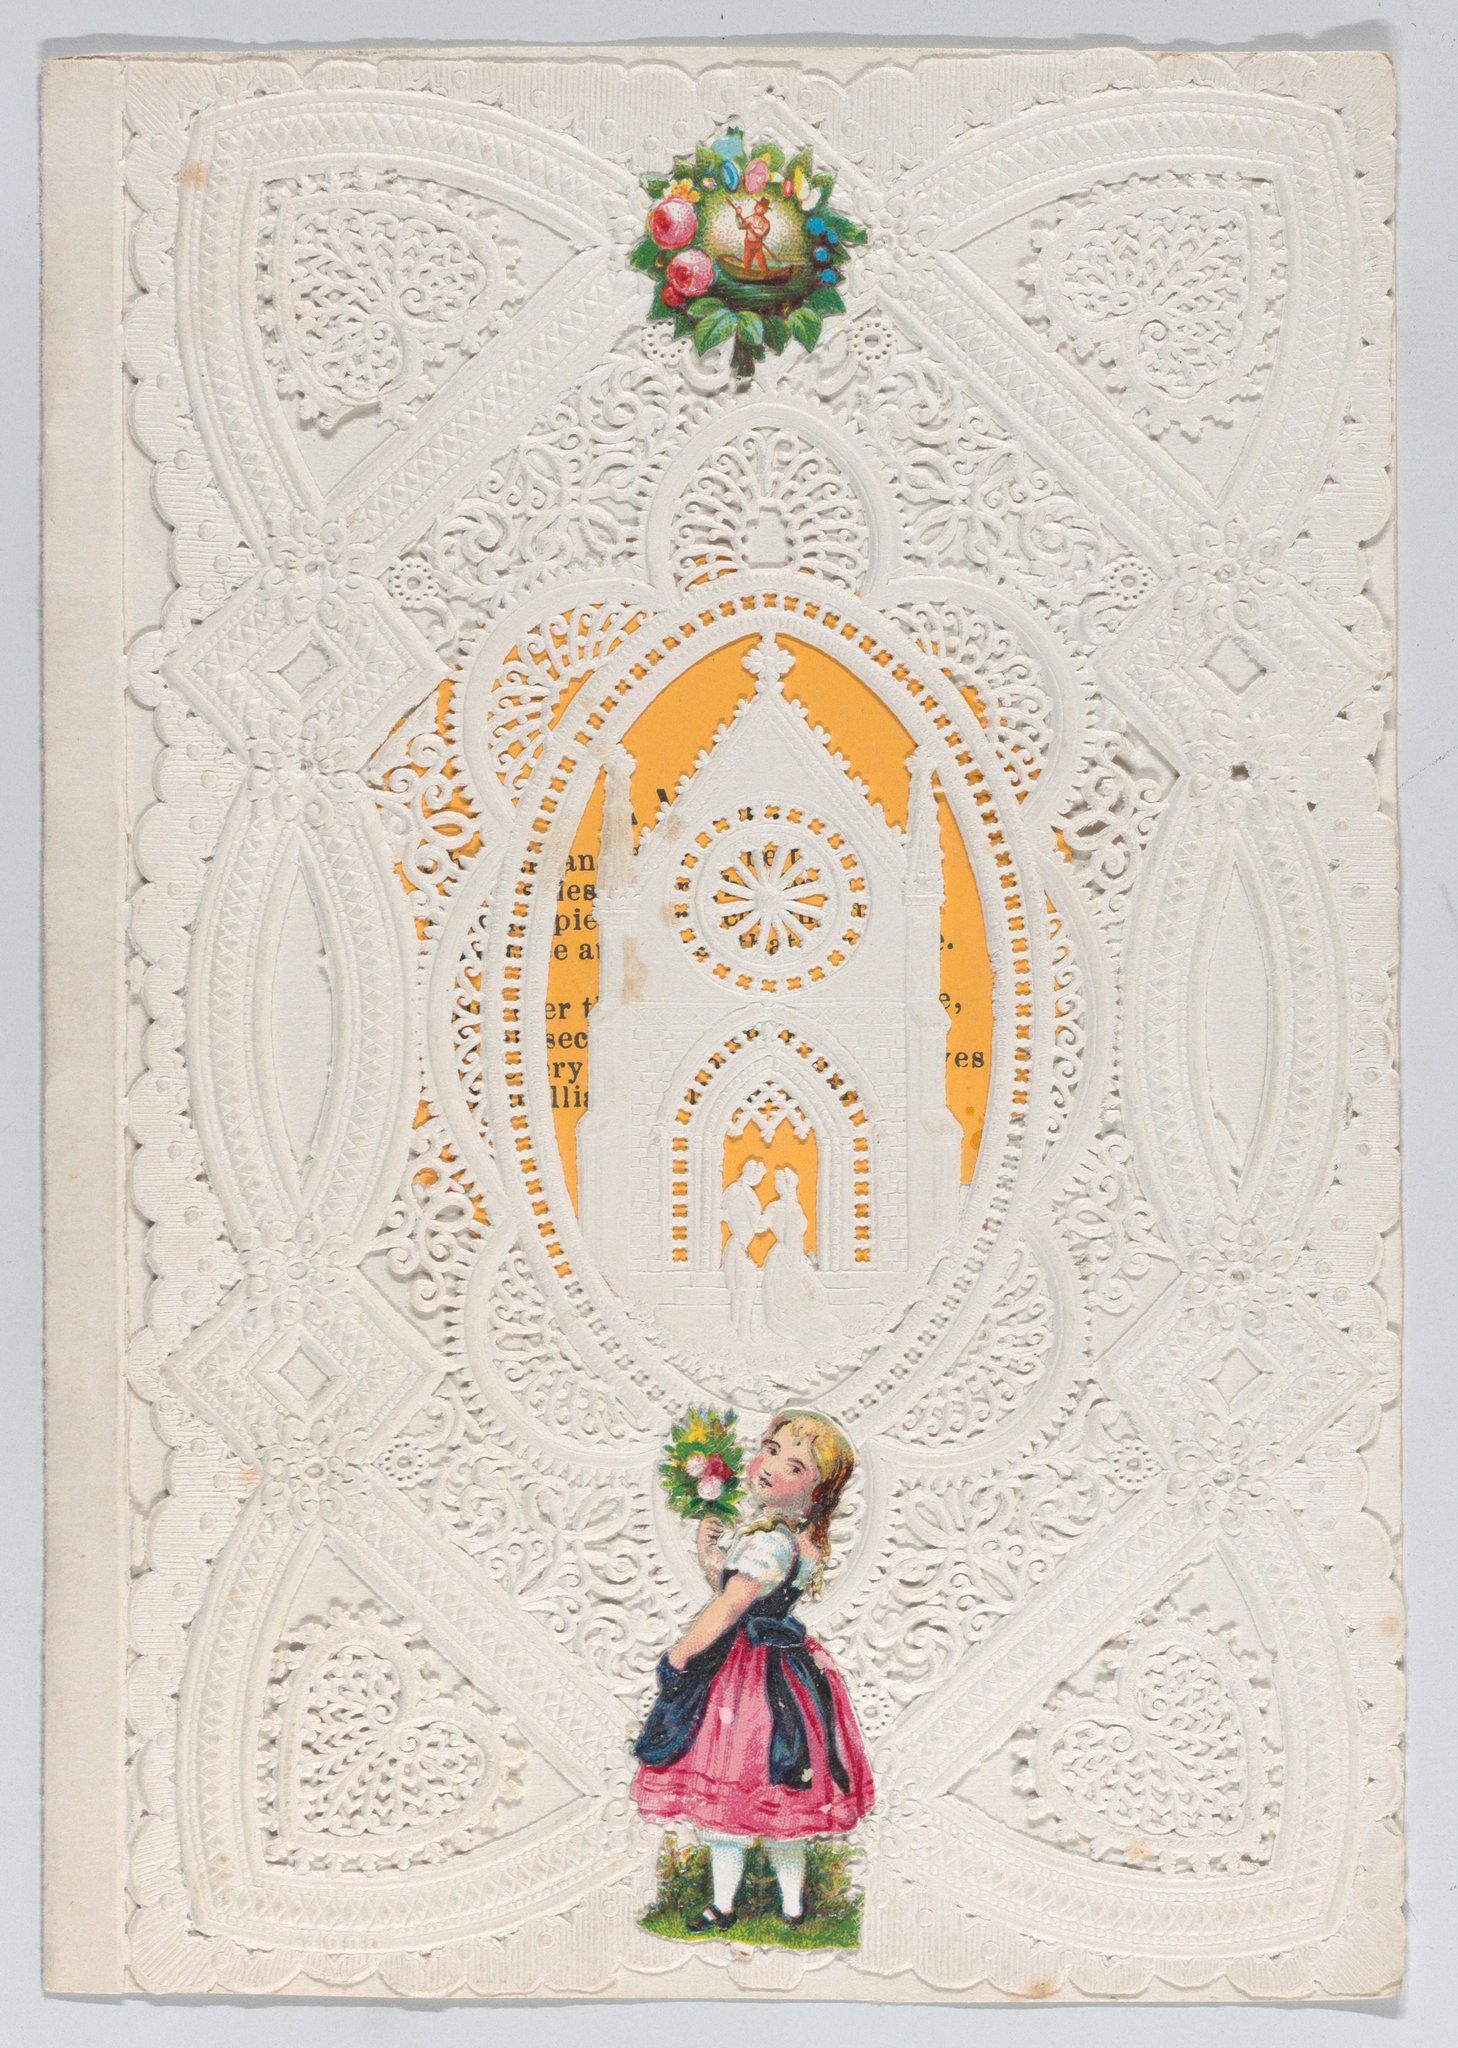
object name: valentine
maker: Anonymous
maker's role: artist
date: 1850-1870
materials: lace, paper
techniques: chromolithography, embossing, open work